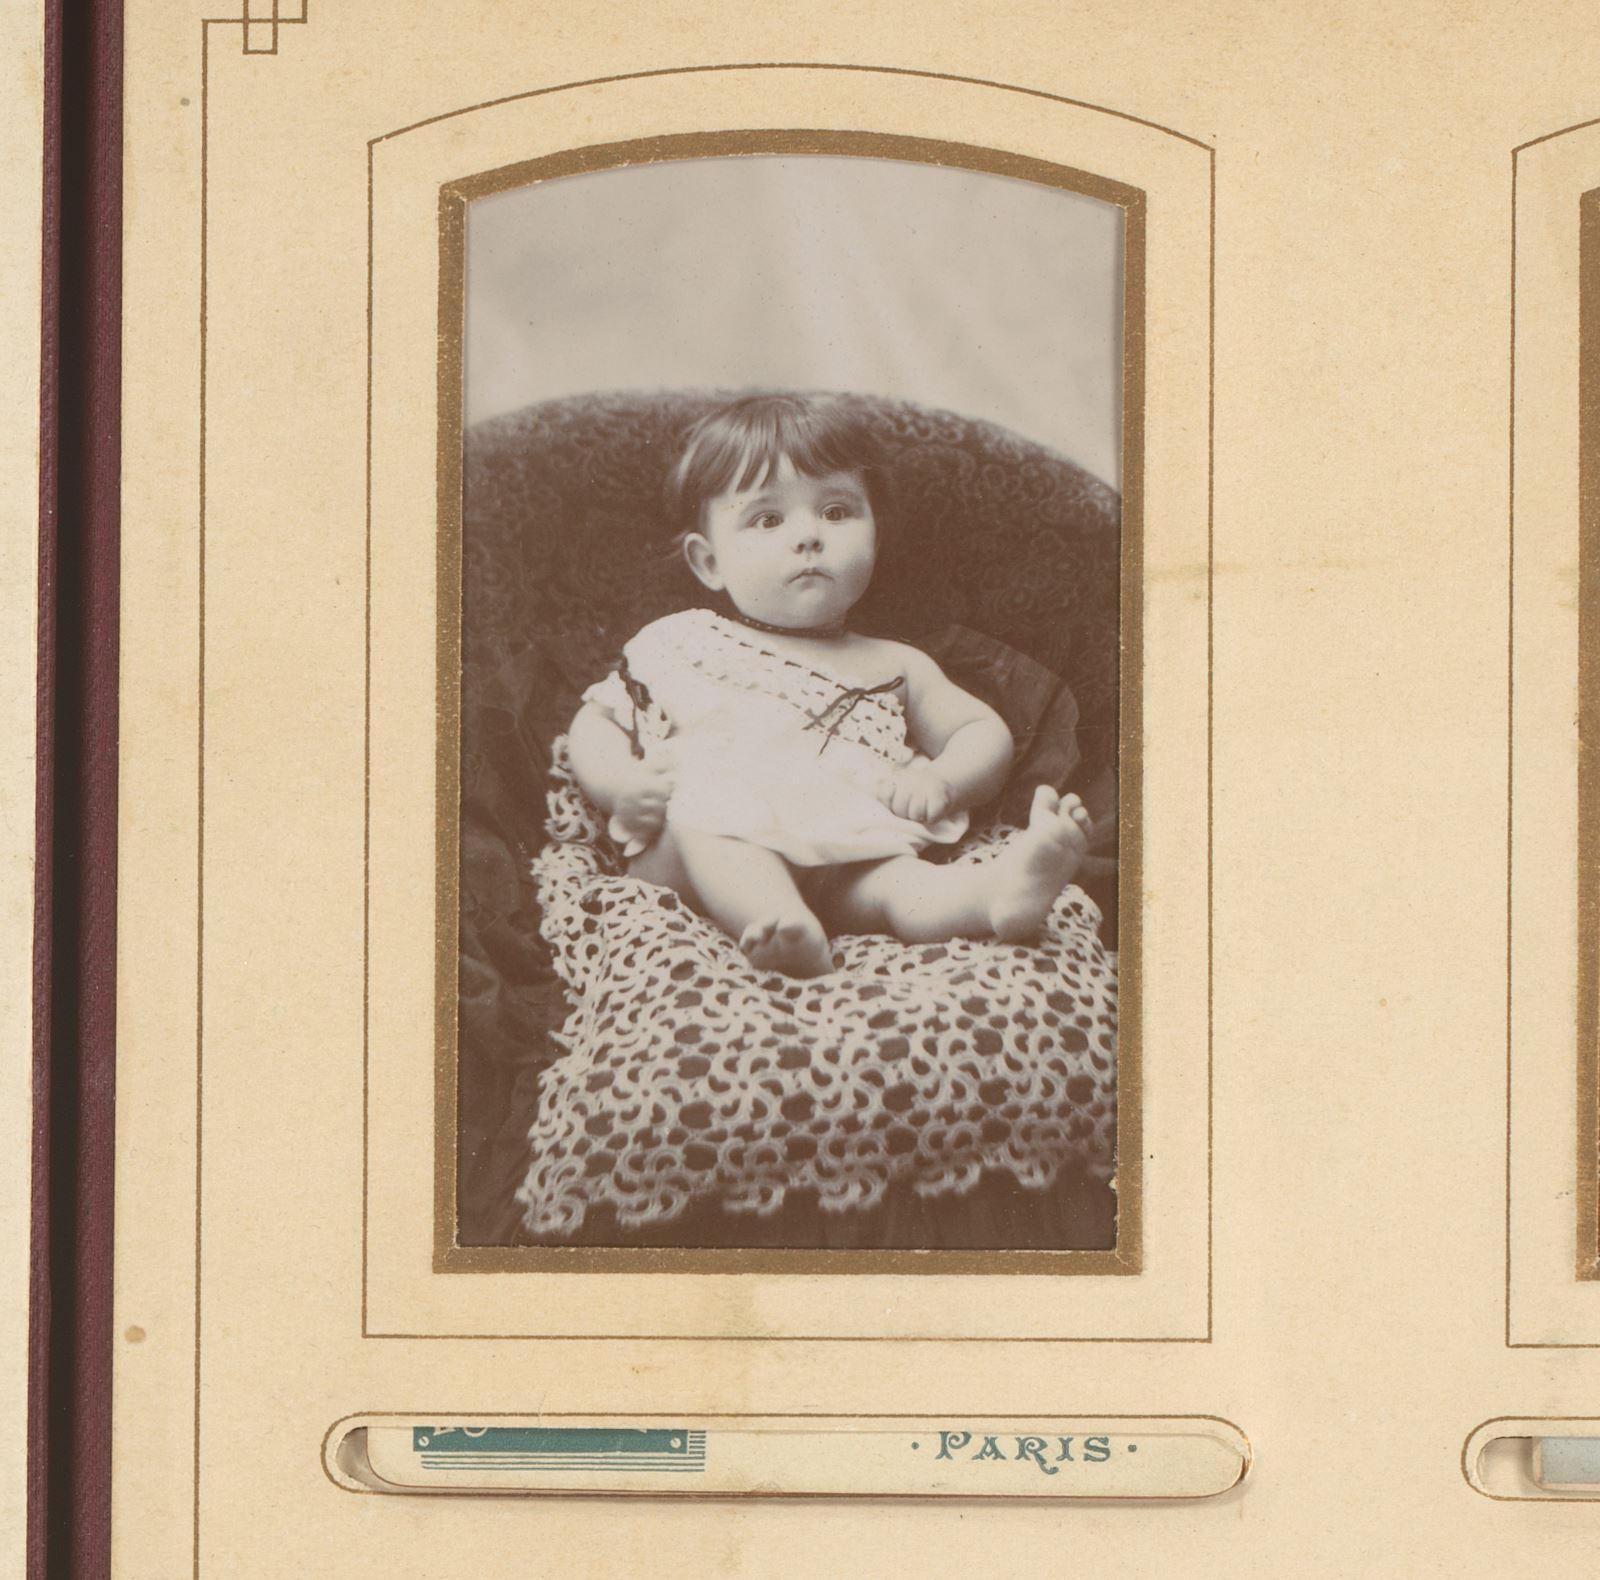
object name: photograph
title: Portret van een meisje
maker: l. sprécher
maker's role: fotograaf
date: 1880-1920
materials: cardboard, photographic support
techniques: collodion silver print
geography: paris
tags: girl (child between toddler and youth)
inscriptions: inscription: ‘L. Spréher/ 154, Faubg St. Antoine/ Paris’